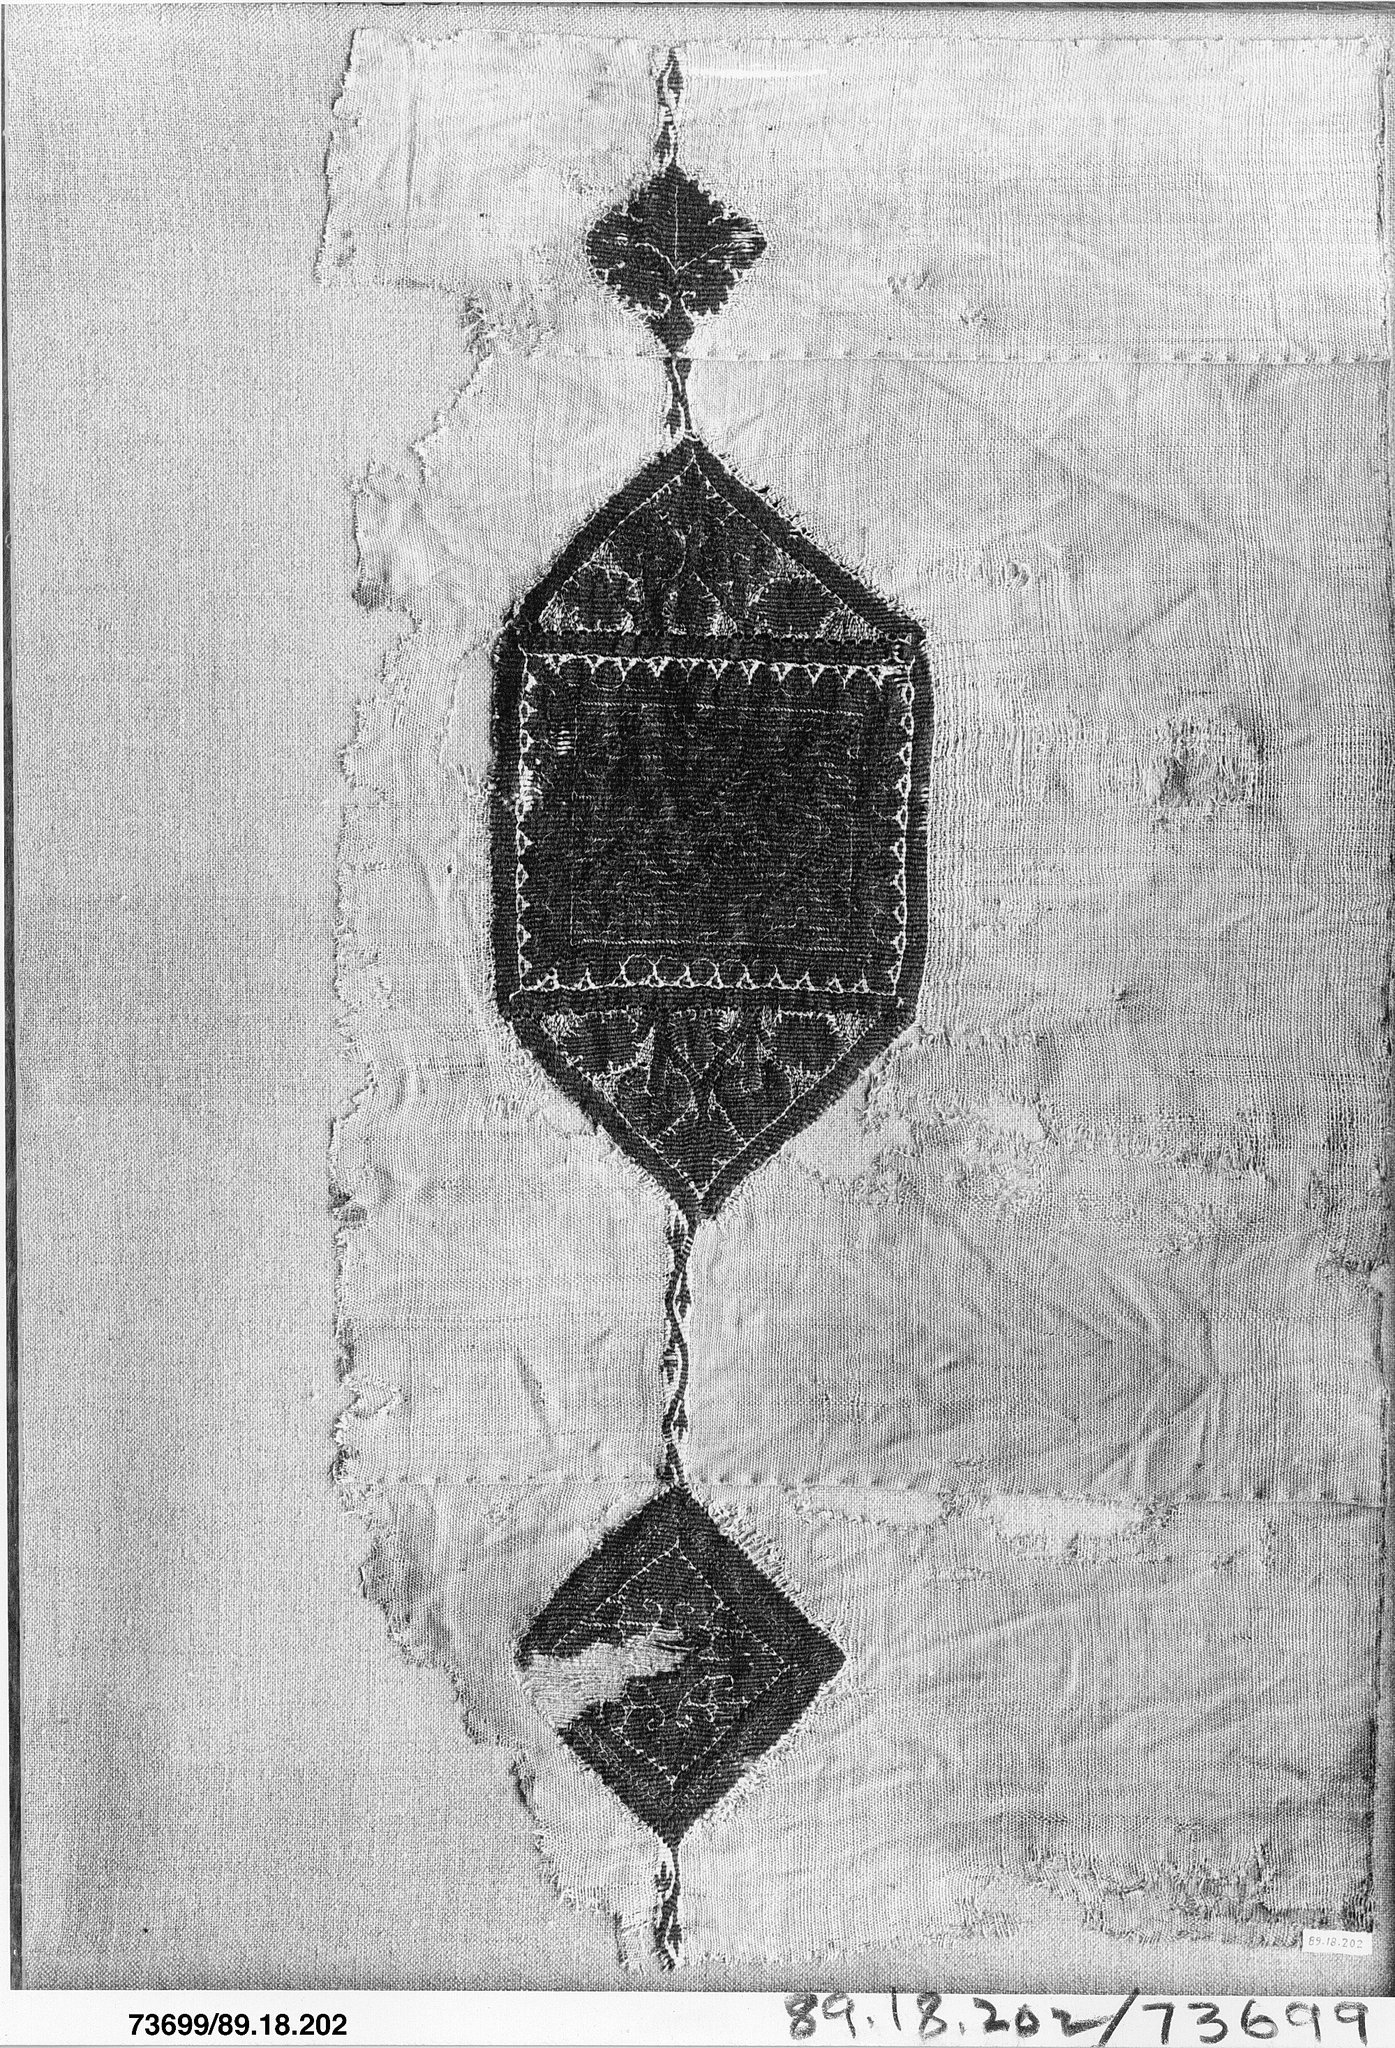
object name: textile fragment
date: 201-400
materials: linen, wool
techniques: weave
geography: egypt